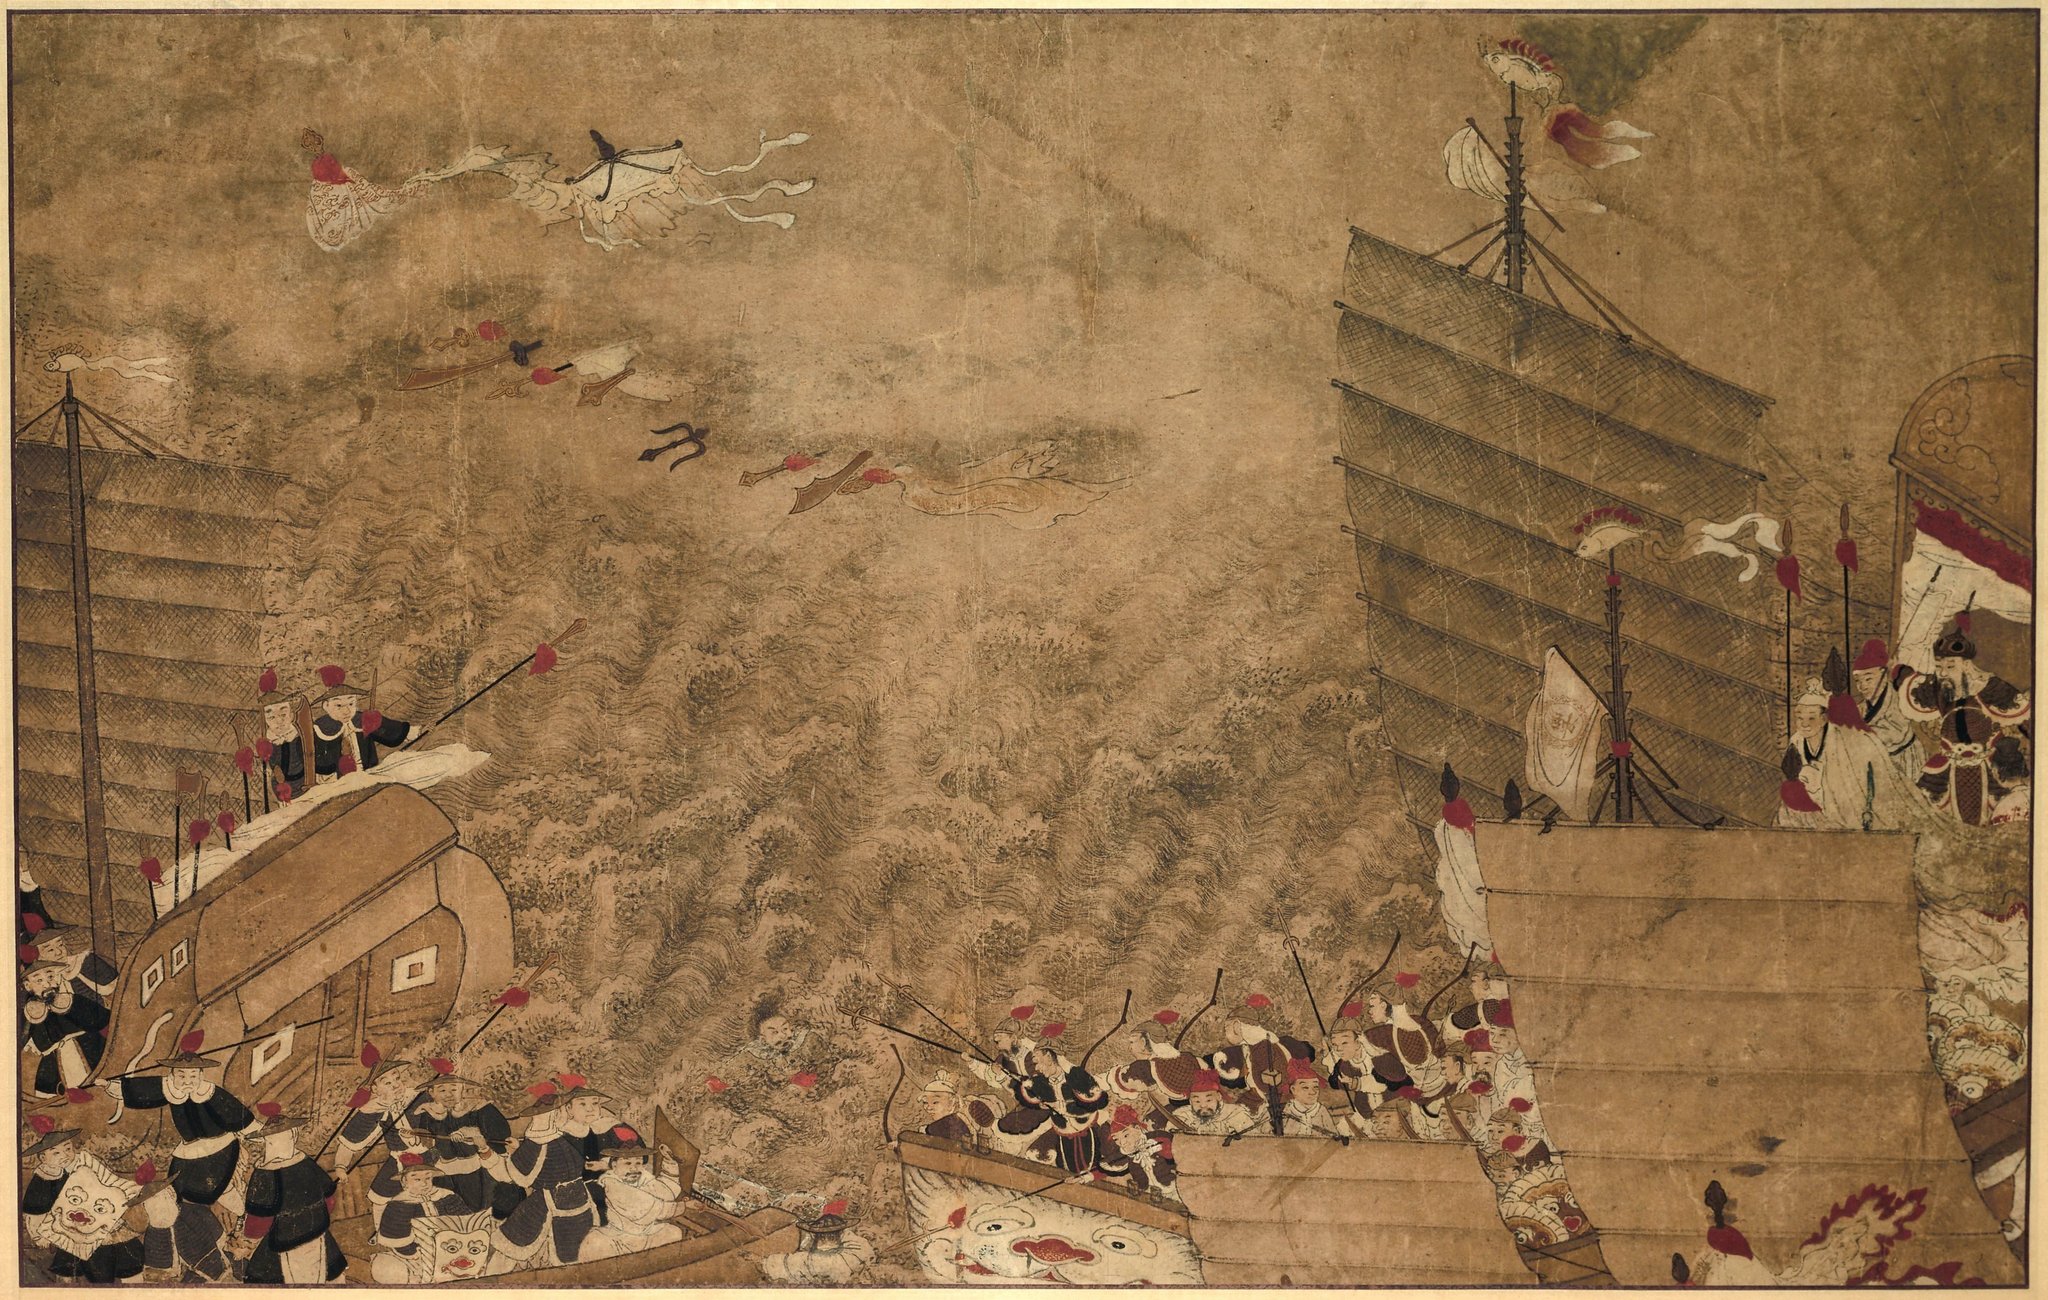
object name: album leaf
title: Een zeeslag tussen Japanse zeerovers en Chinezen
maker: Anonymous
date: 1700-1800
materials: ink, paper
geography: china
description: Eén van een serie van zeven schilderingen die samen de wonderen van Mazu voorstellen.